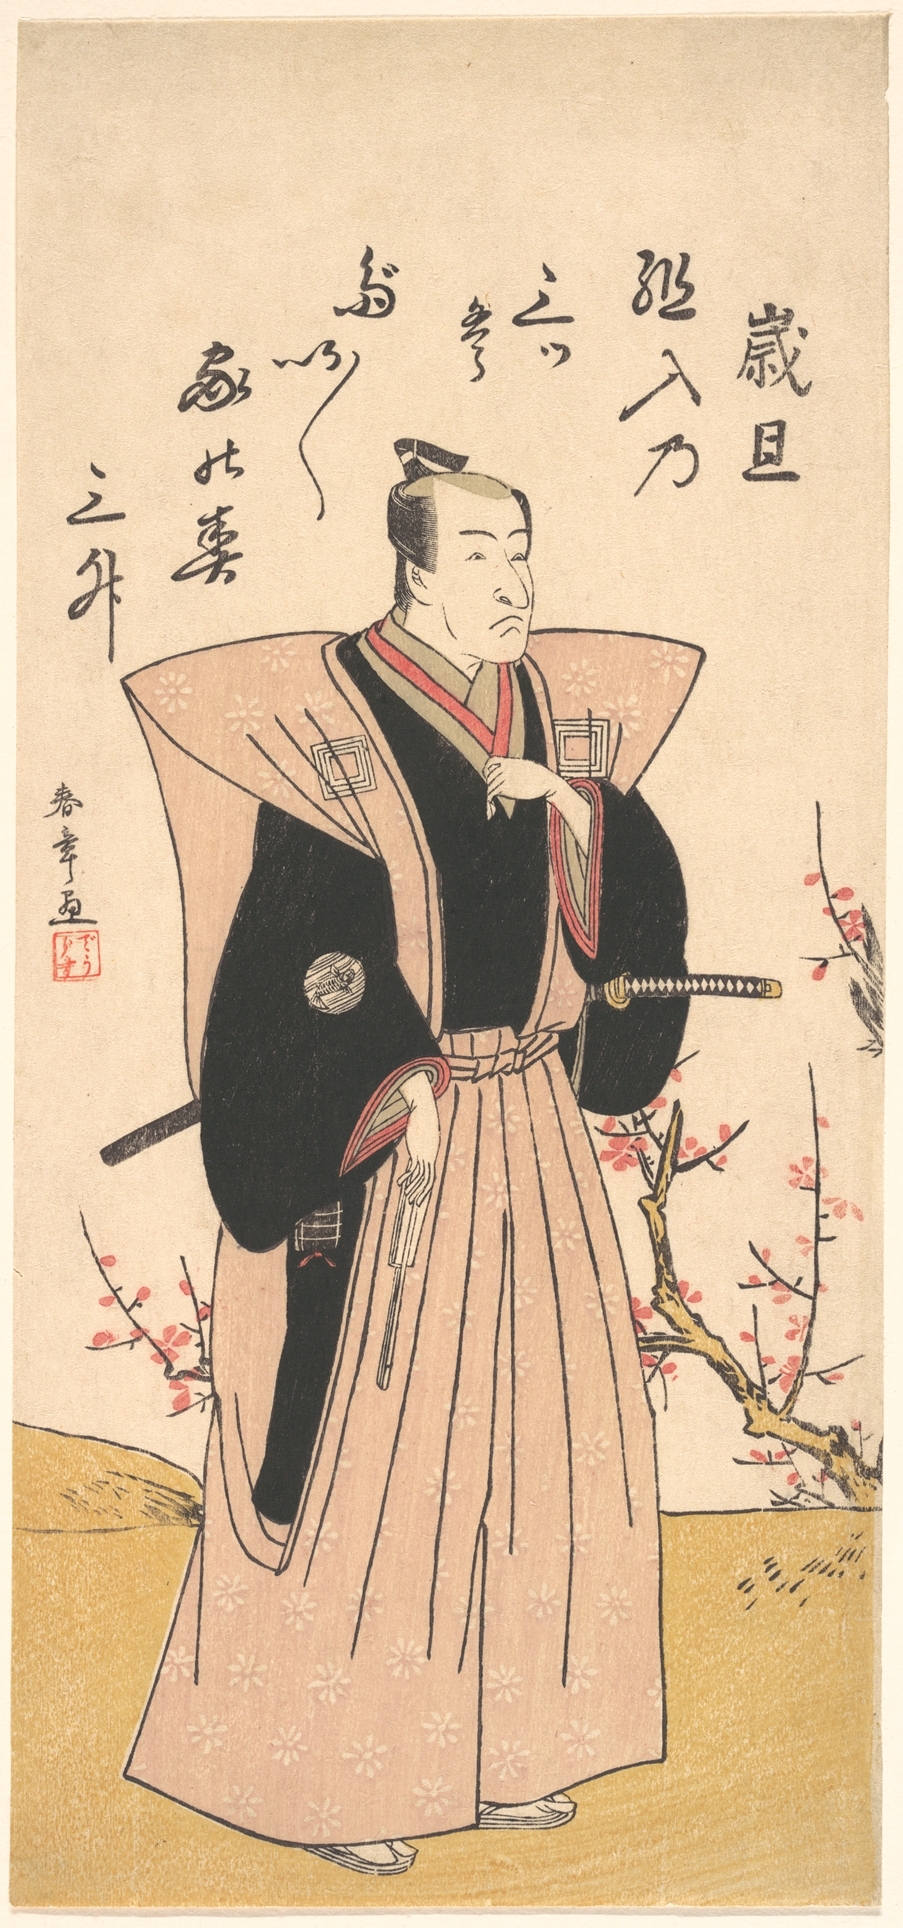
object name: woodblock print nishiki e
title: Ichikawa Danjuro V in Ceremonial Robes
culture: japanese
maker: katsukawa shunshō 勝川春章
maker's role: artist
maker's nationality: japanese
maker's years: 1726-1792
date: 1786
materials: ink, paper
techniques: nishiki e, woodblock print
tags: swords,men